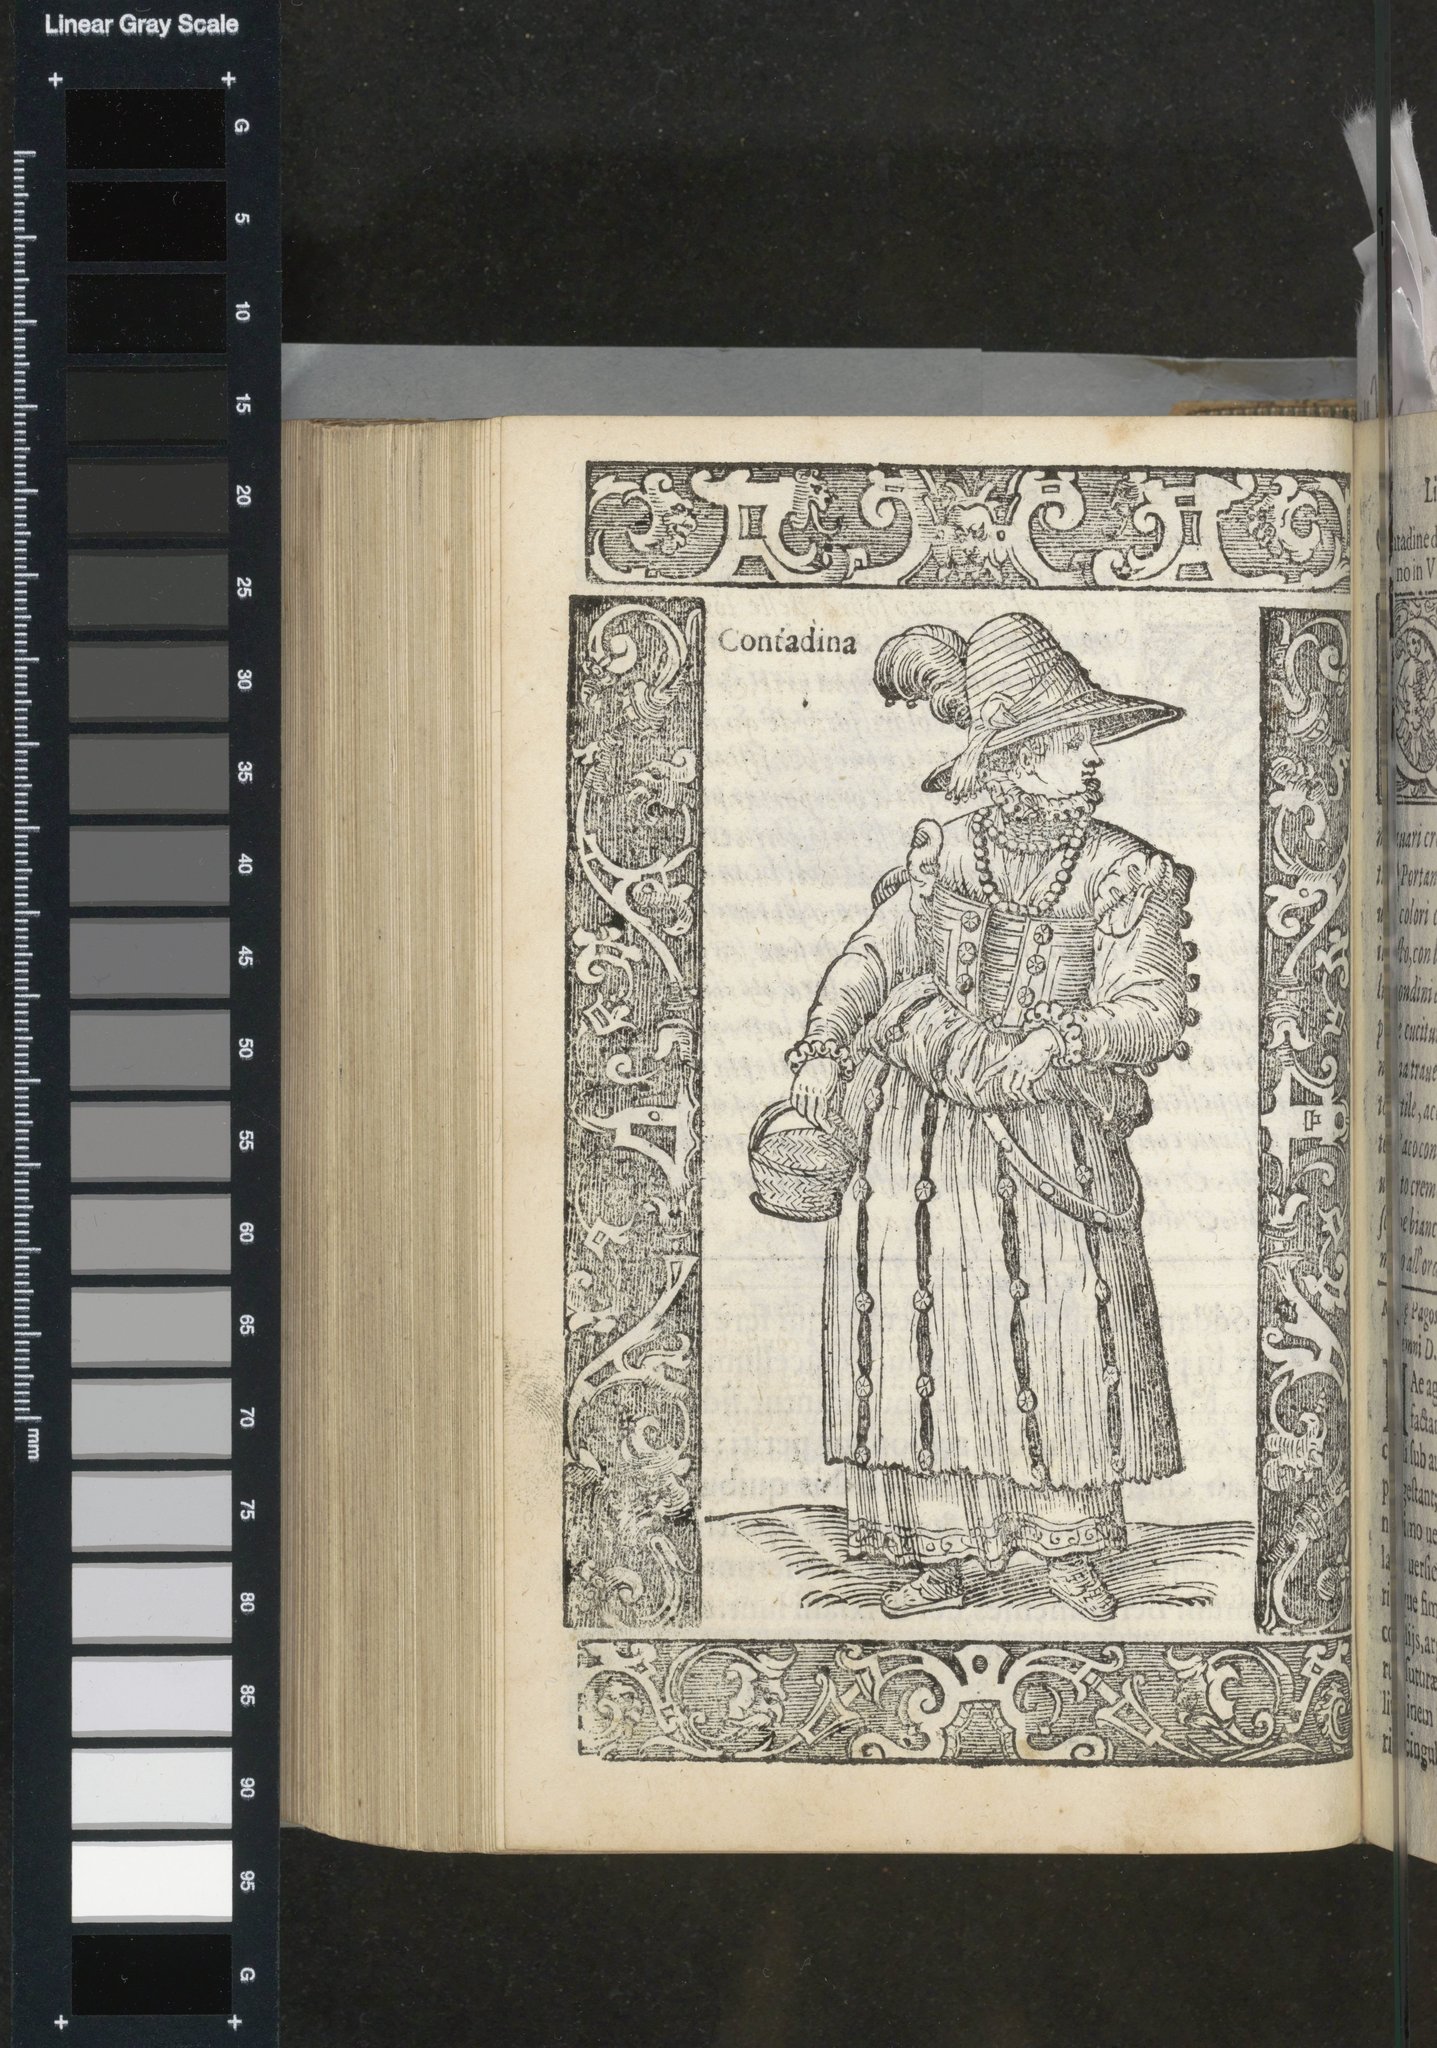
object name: costume print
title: Contadina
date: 1598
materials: paper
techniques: woodcut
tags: fashion plates